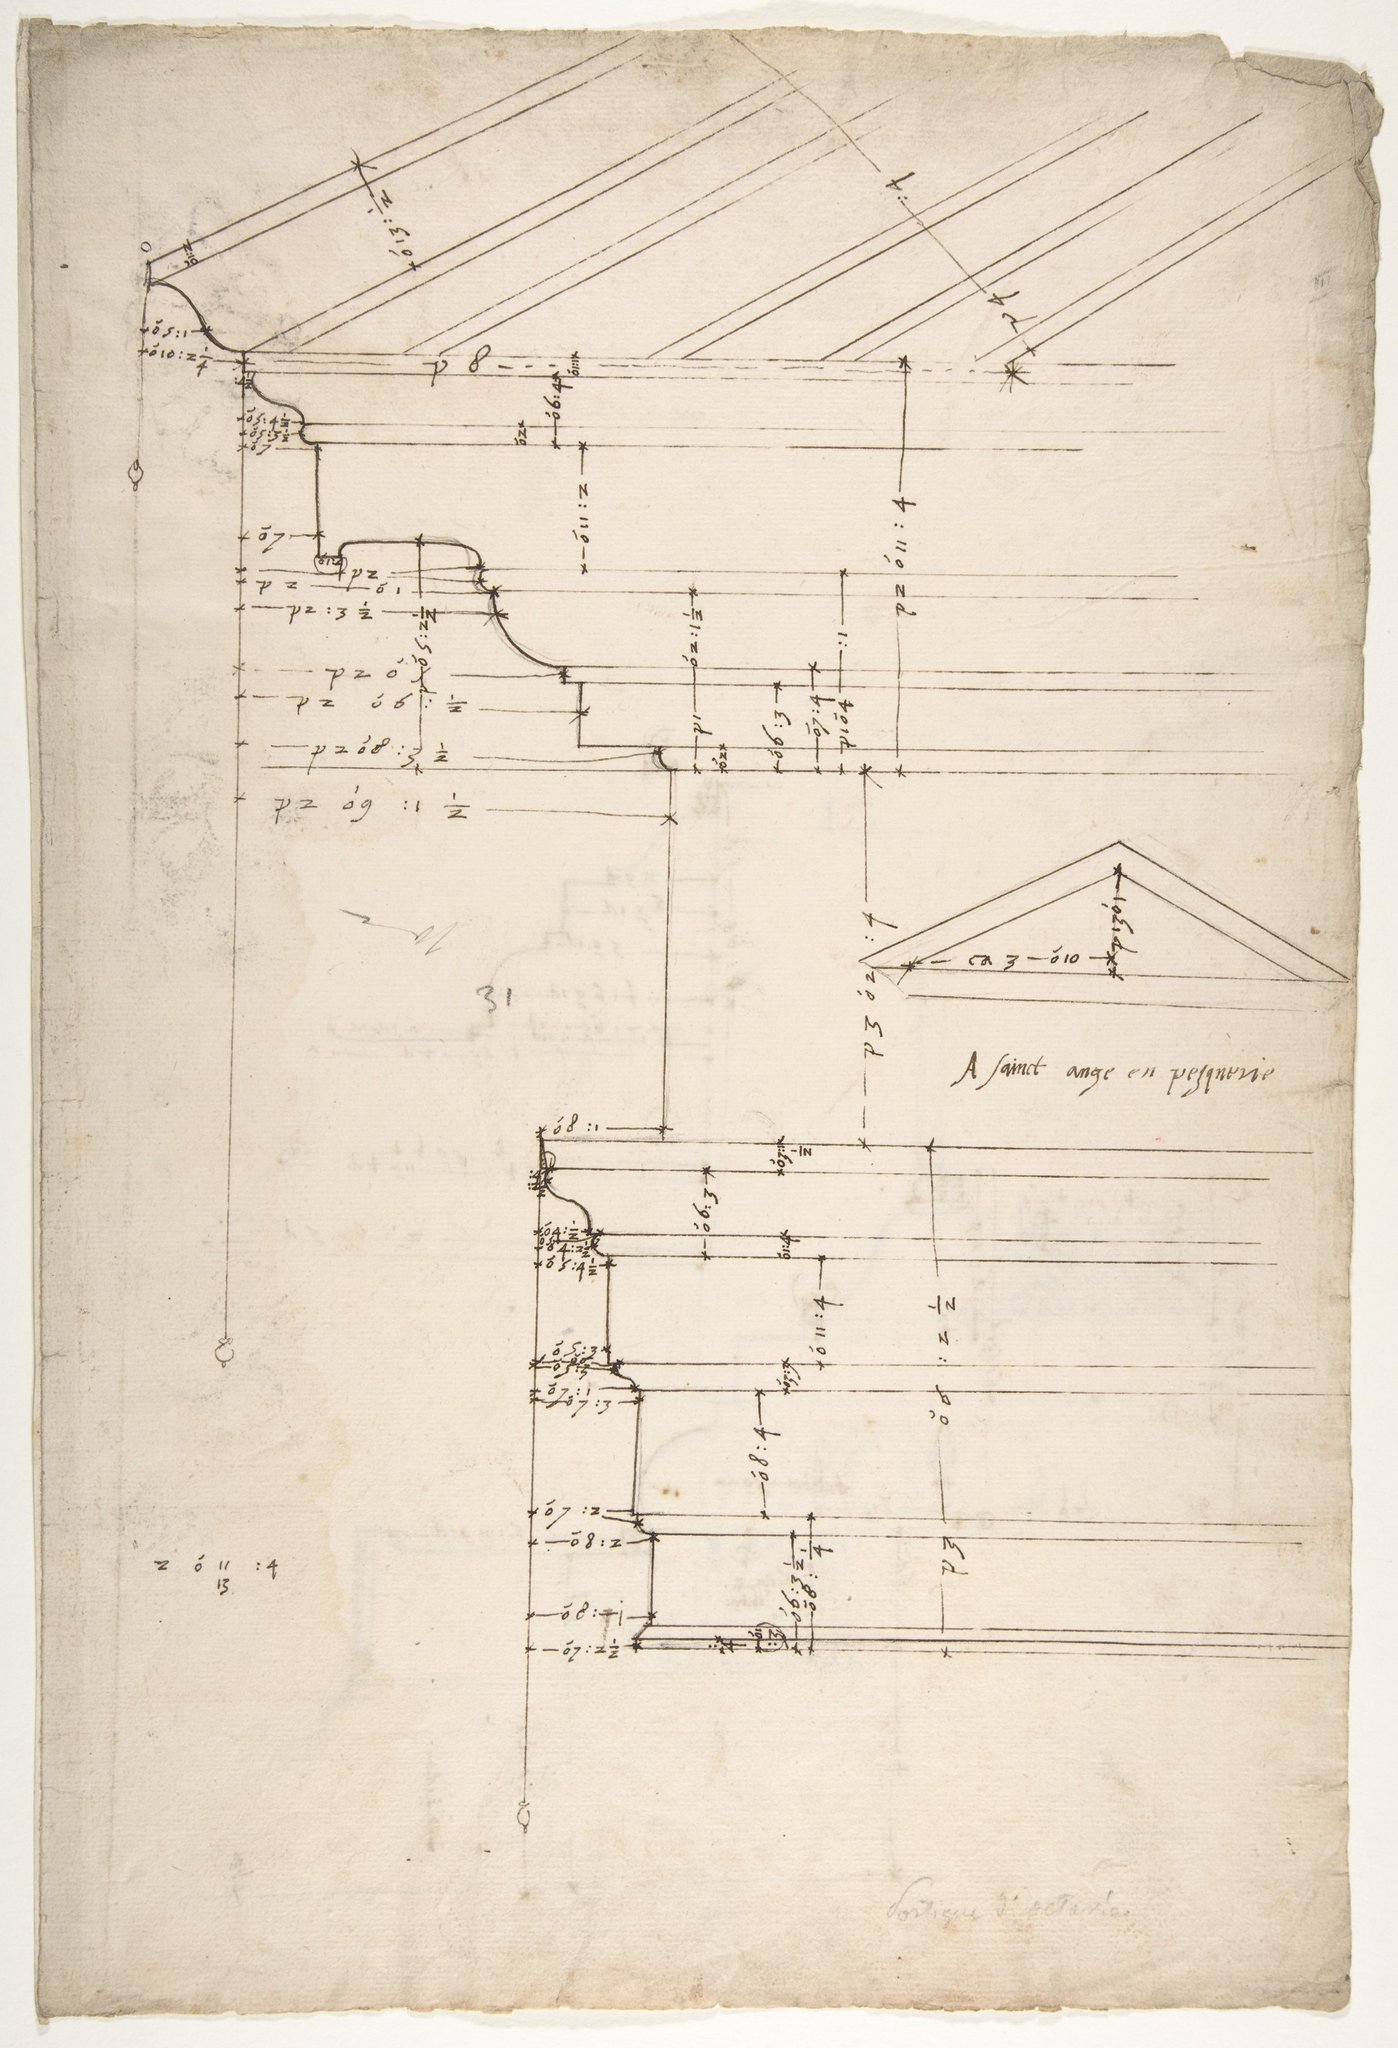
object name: collection ornament architecture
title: Portico Octavia, pediment and entablature, elevation; pediment, elevation (recto) Temple of Antoninus and Faustina, entablature, elevation (verso)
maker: anonymous, french, 16th century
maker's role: draftsman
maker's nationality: french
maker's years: 1500-1600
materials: chalk, ink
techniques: incising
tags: architecture